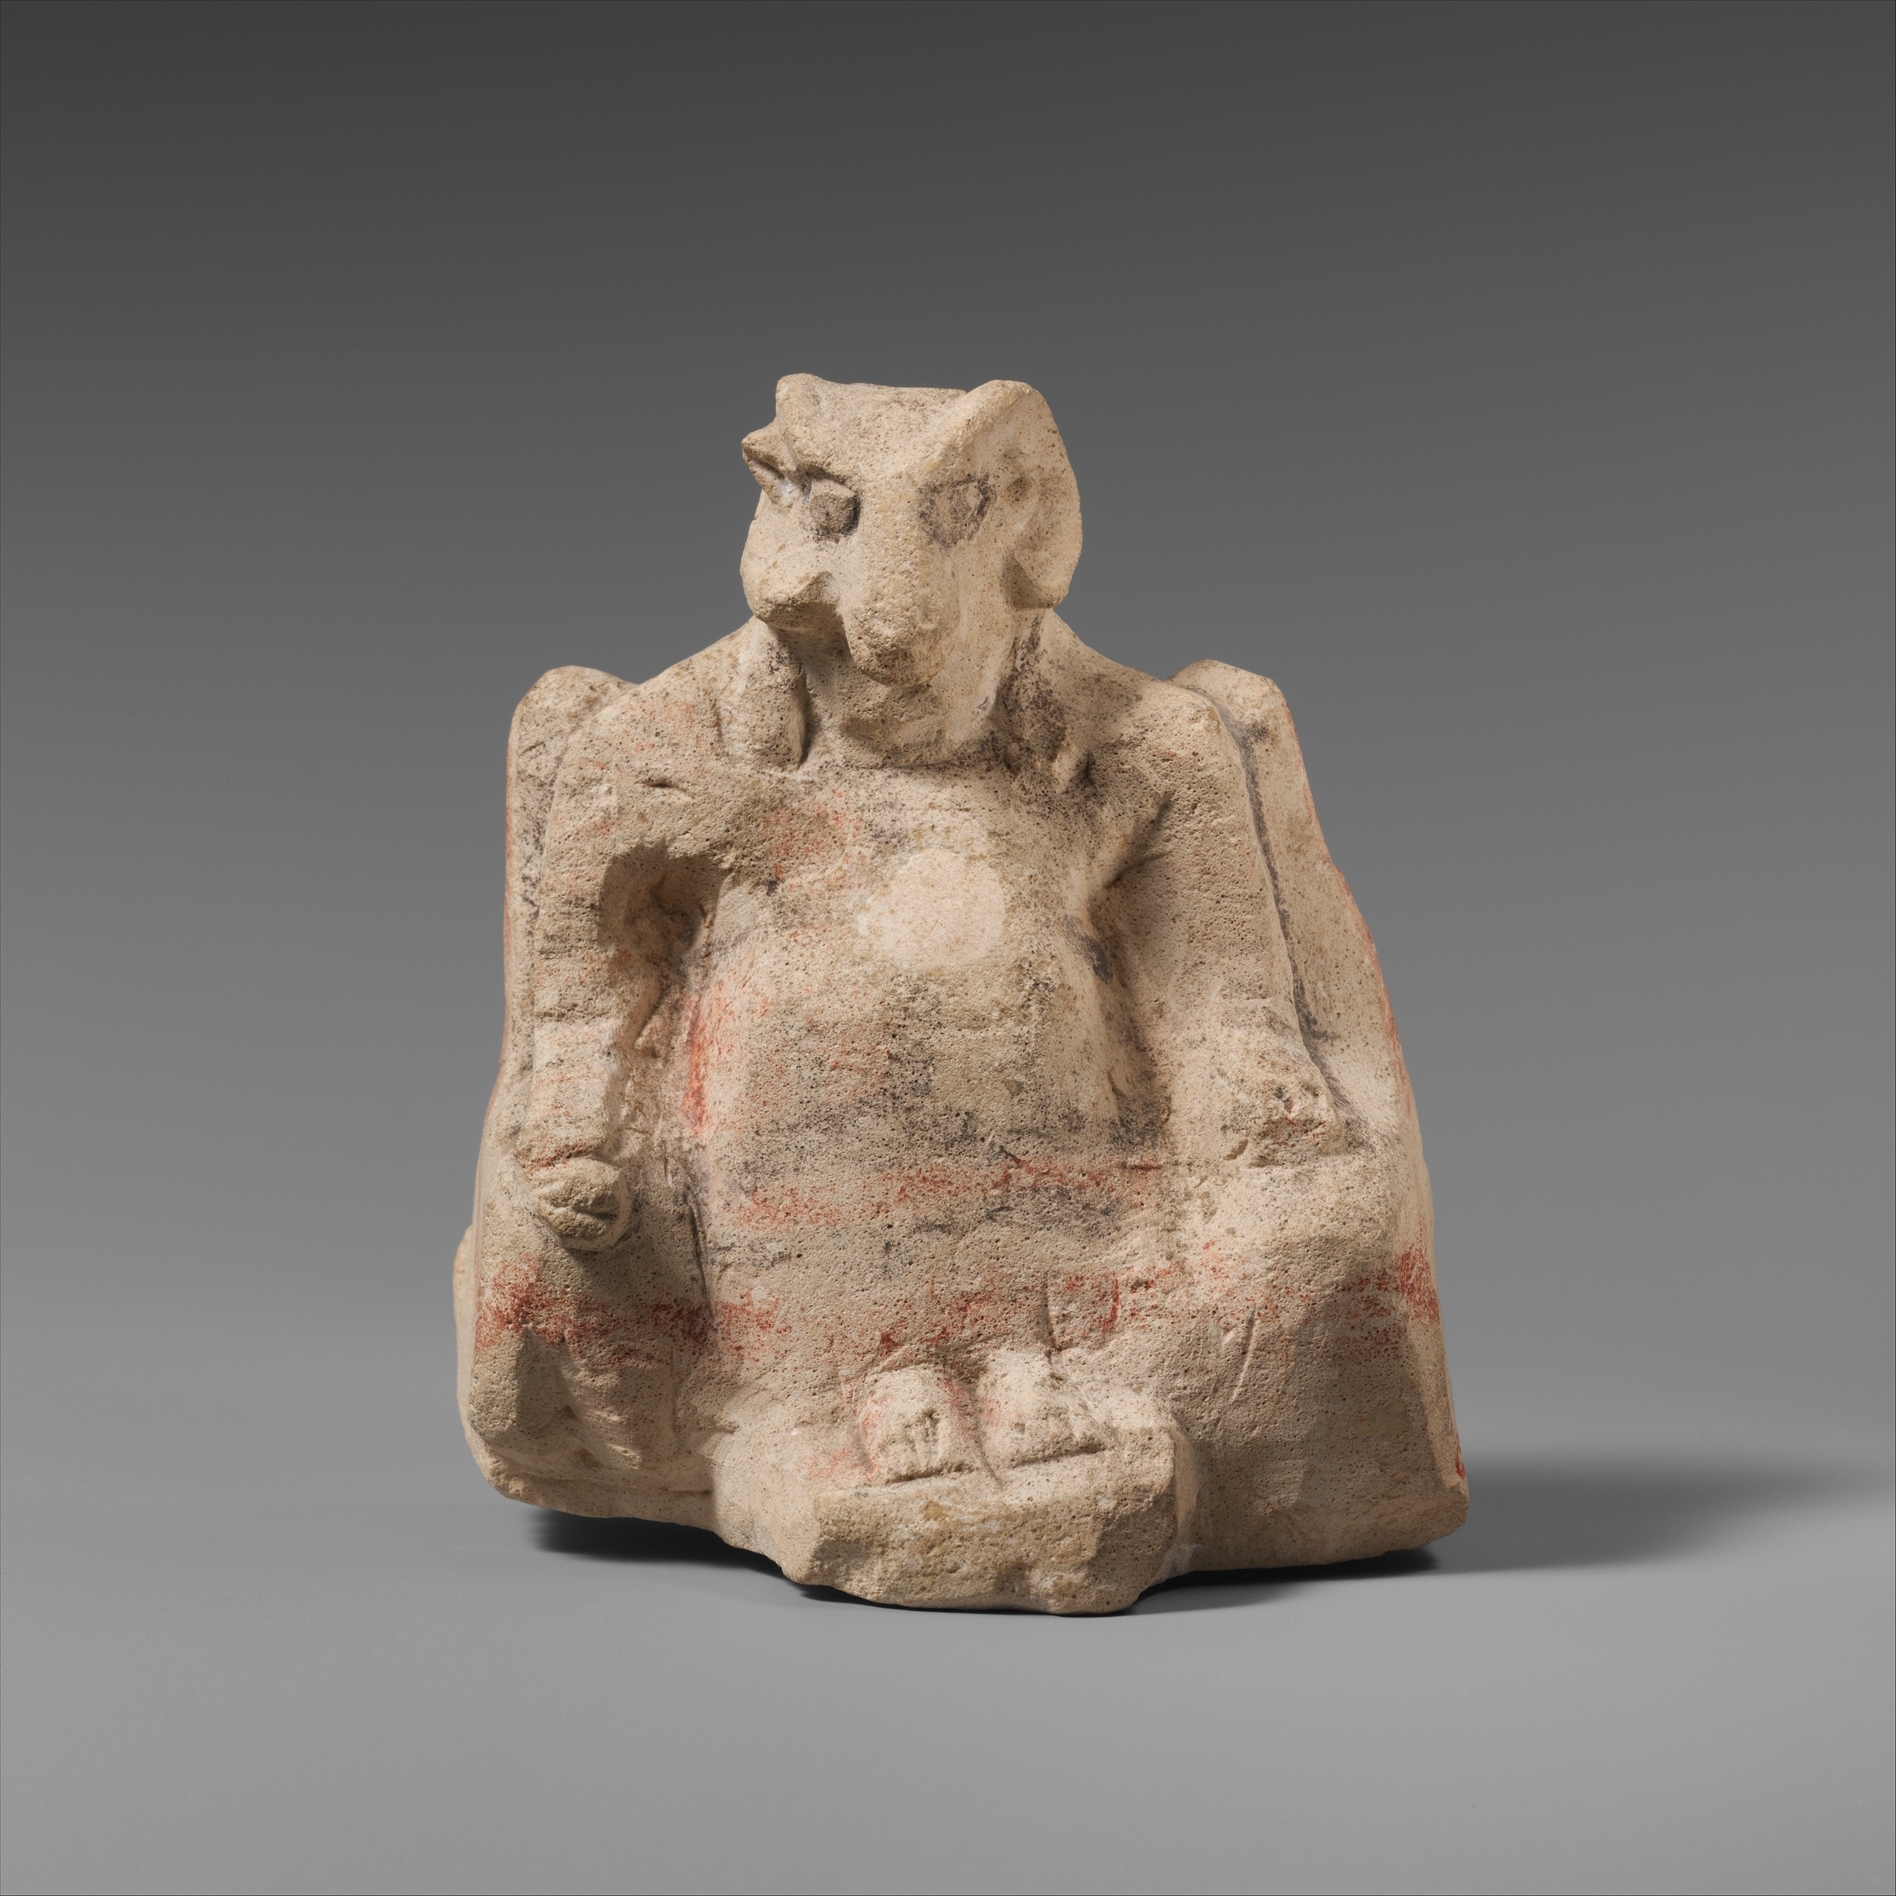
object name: statuette of zeus ammon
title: Limestone statuette of Zeus Ammon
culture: cypriot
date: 575-551 BCE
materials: limestone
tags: zeus